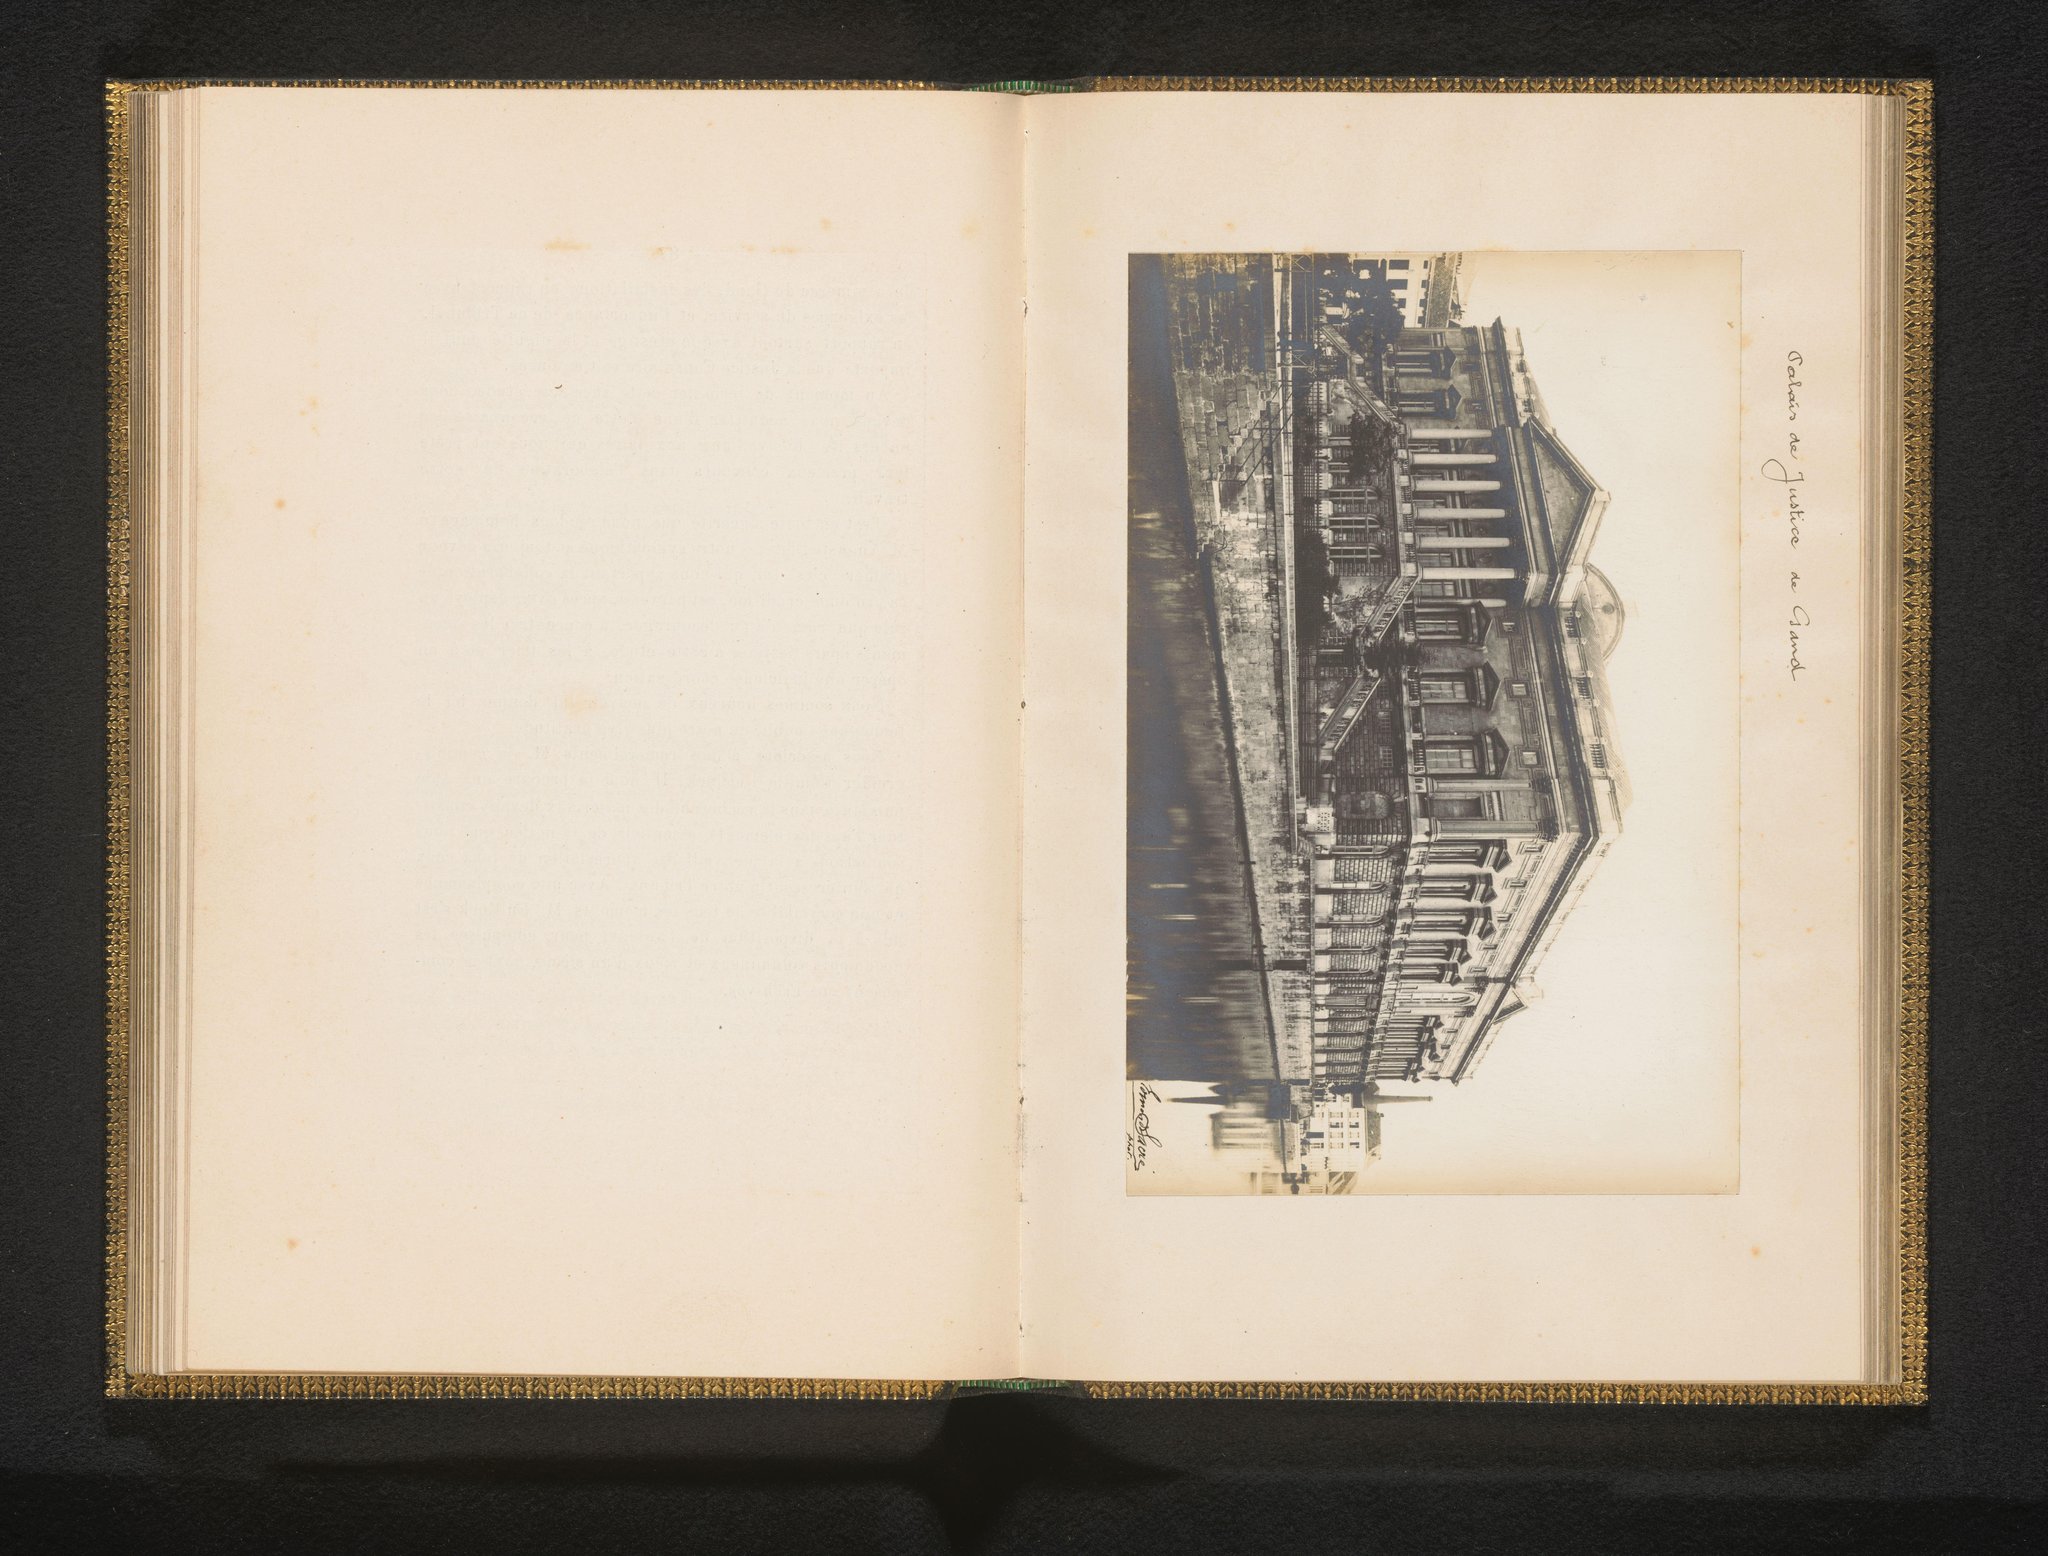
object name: page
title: Gezicht op het gerechtsgebouw in Gent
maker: edmond sacré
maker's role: fotograaf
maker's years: 1851-1921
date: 1894-1899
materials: photographic support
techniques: gelatin silver print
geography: ghent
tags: court building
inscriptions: inscription: ‘Palais de Justice au Gand’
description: Foto op tweede ongenummerde pagina na pagina 87.